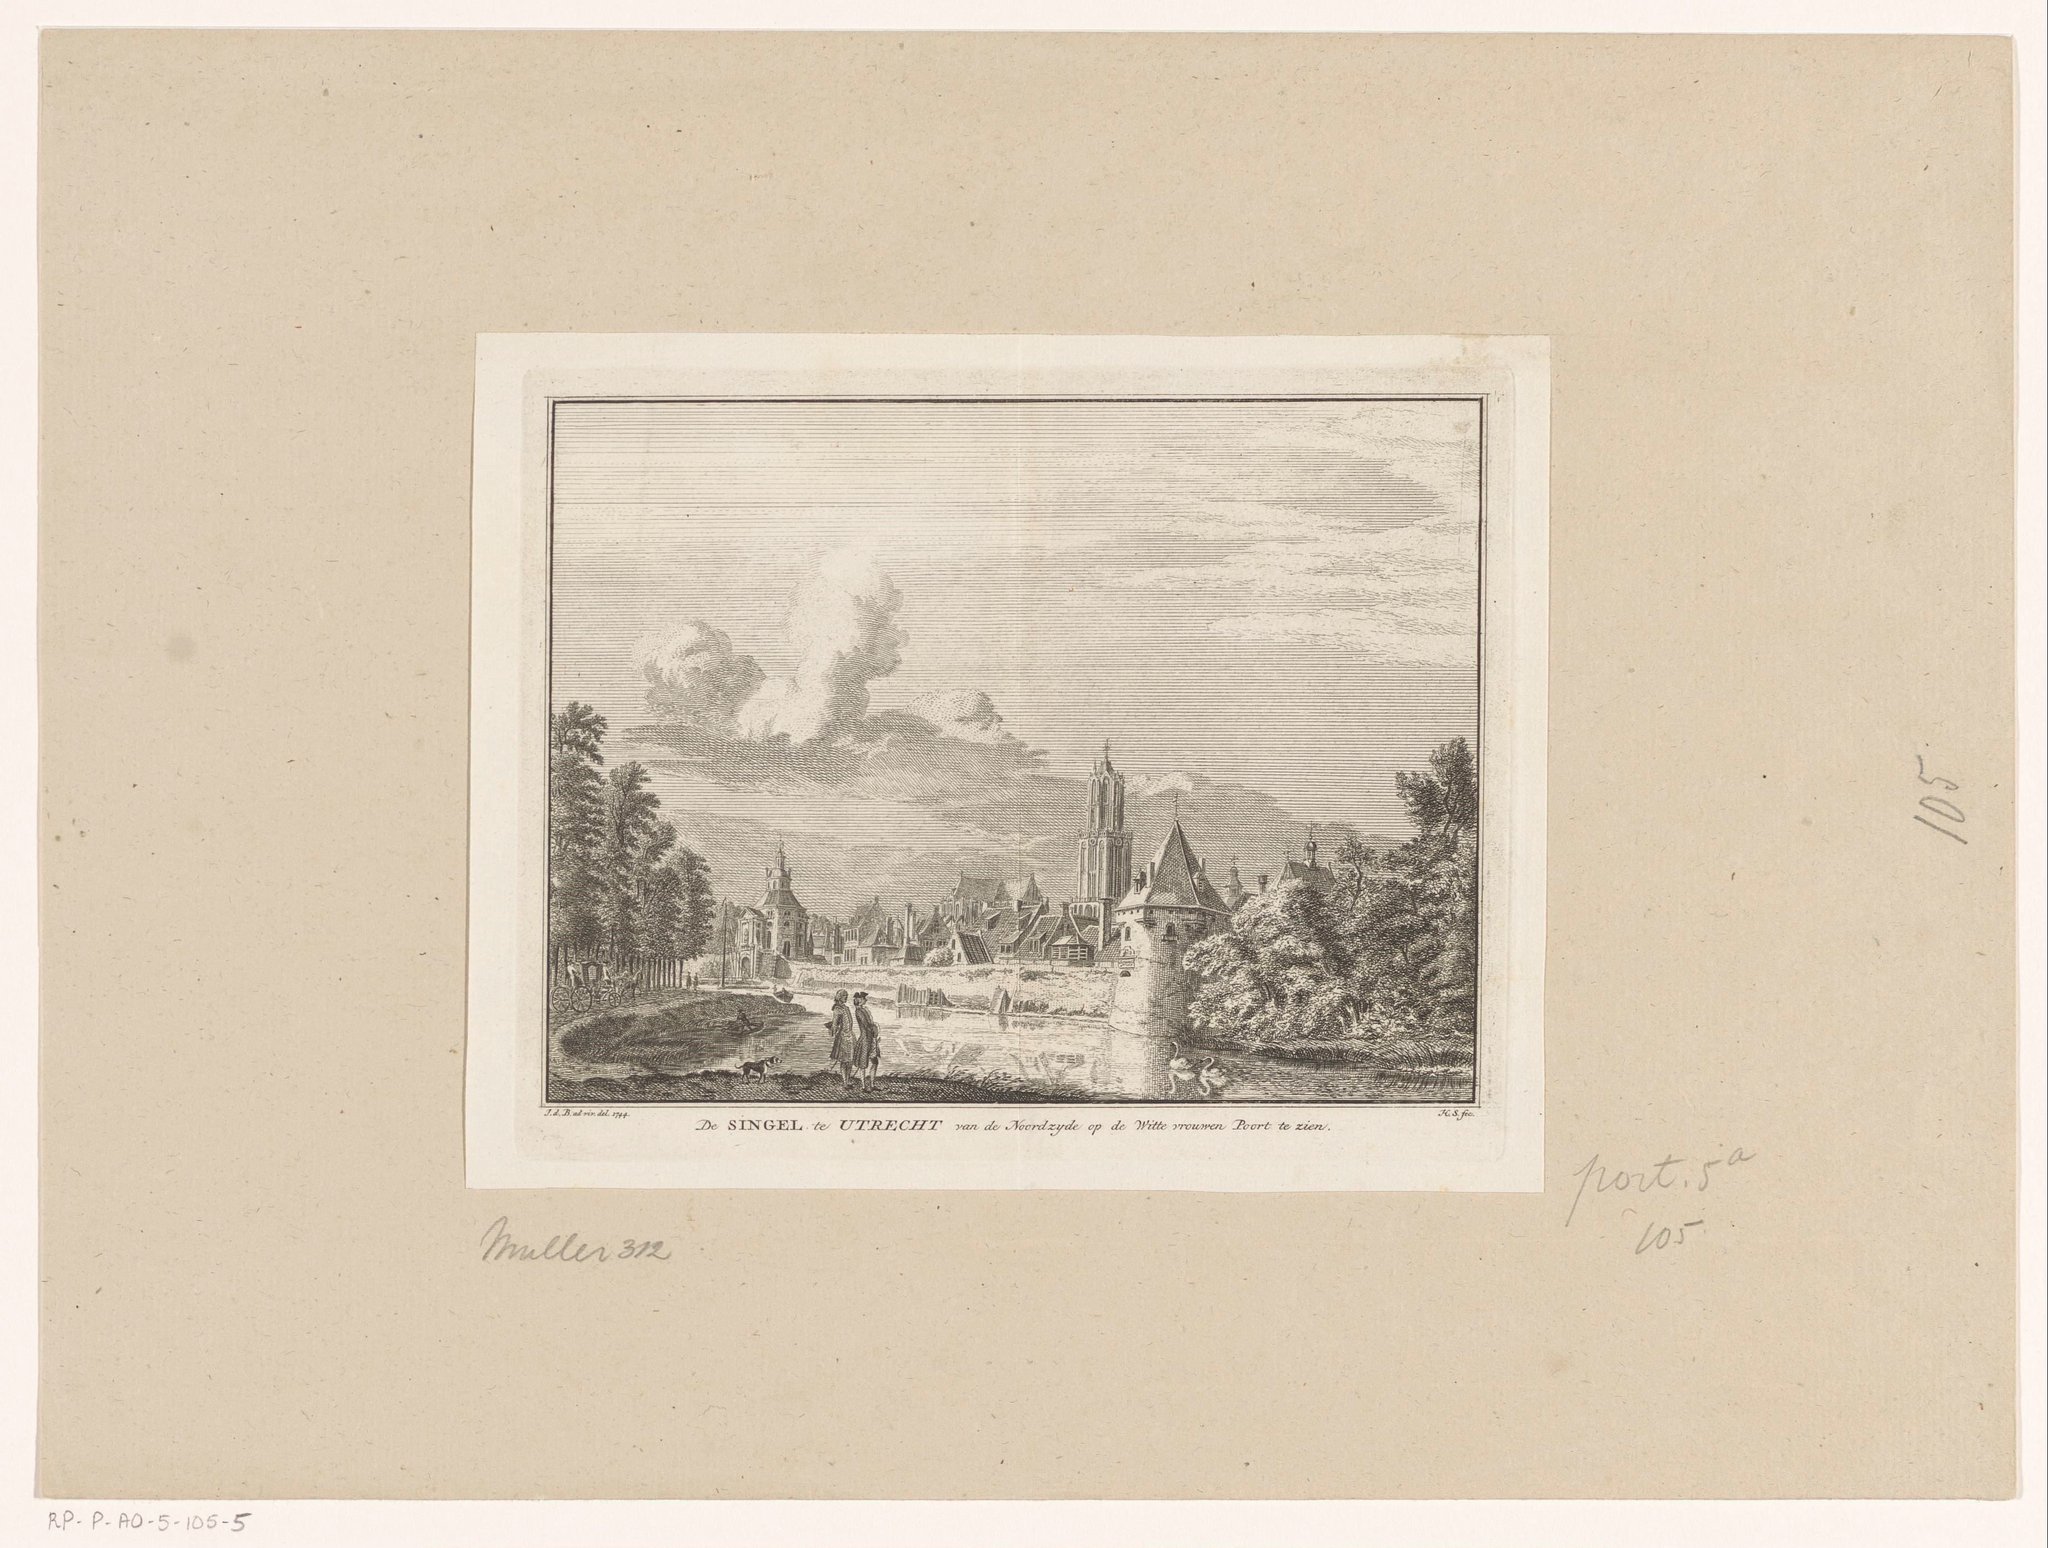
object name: print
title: De Singel te Utrecht van de noordzyde op de Witte vrouwen poort te zien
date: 1773-1792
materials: paper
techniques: engraving, etching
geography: haarlem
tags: towers ~ fortified city, city-walls, city-gate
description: Prent ook gebruikt in: Het verheerlykt Nederland of kabinet van hedendaagsche gezigten van steden, dorpen (…) Behelzende honderd gezigten van der Provincie van Utrecht. Amsterdam: weduwe Isaak Tirion, 1773-1774, dl. 7, 8 of 9, niet genummerd, te vinden na ill. 144 en voor ill. 201. Of in: Nederlandsche tafereelen; of eene keurige verzameling van negen honderd fraaije gezigten van steden, dorpen, sloten, oudheden (….). 9 delen. Amsterdam: Jan de Groot, 1792, dl. 7, 8 of 9, niet genummerd, te vinden na ill. 144 en voor ill. 201. Uit welke druk het huidige exemplaar precies komt is niet na te gaan.